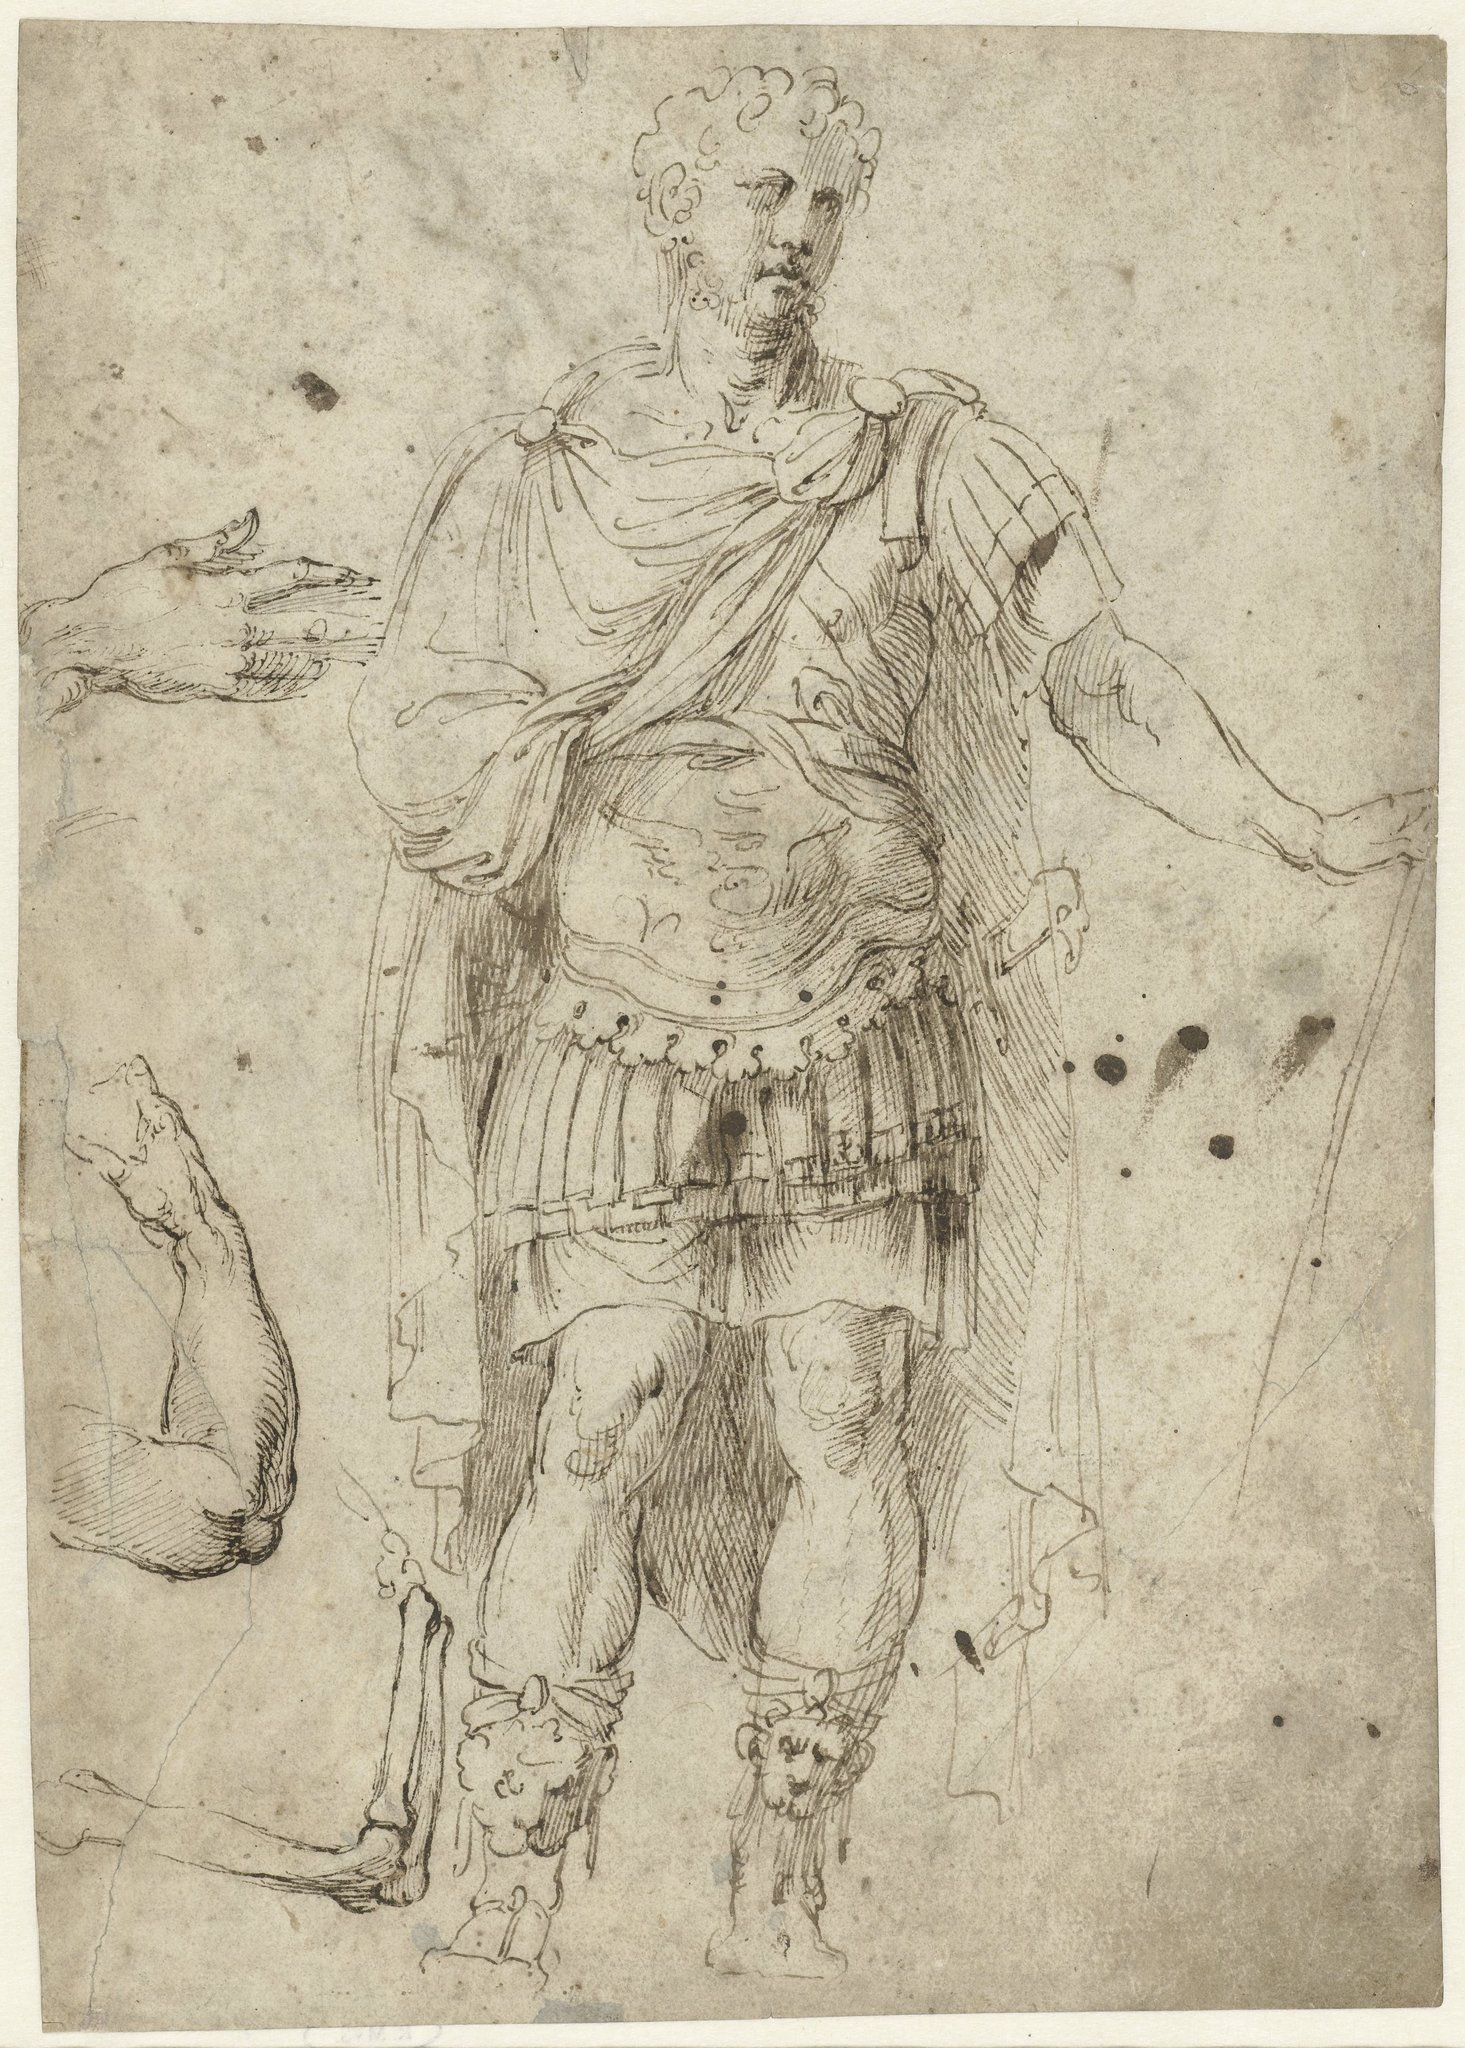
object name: drawing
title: Schets van keizer Trajanus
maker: girolamo da carpi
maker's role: draughtsman, painter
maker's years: 1501-1556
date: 1511-1556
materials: ink, paper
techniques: pen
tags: keizer, trajanus (keizer van het romeinse rijk)